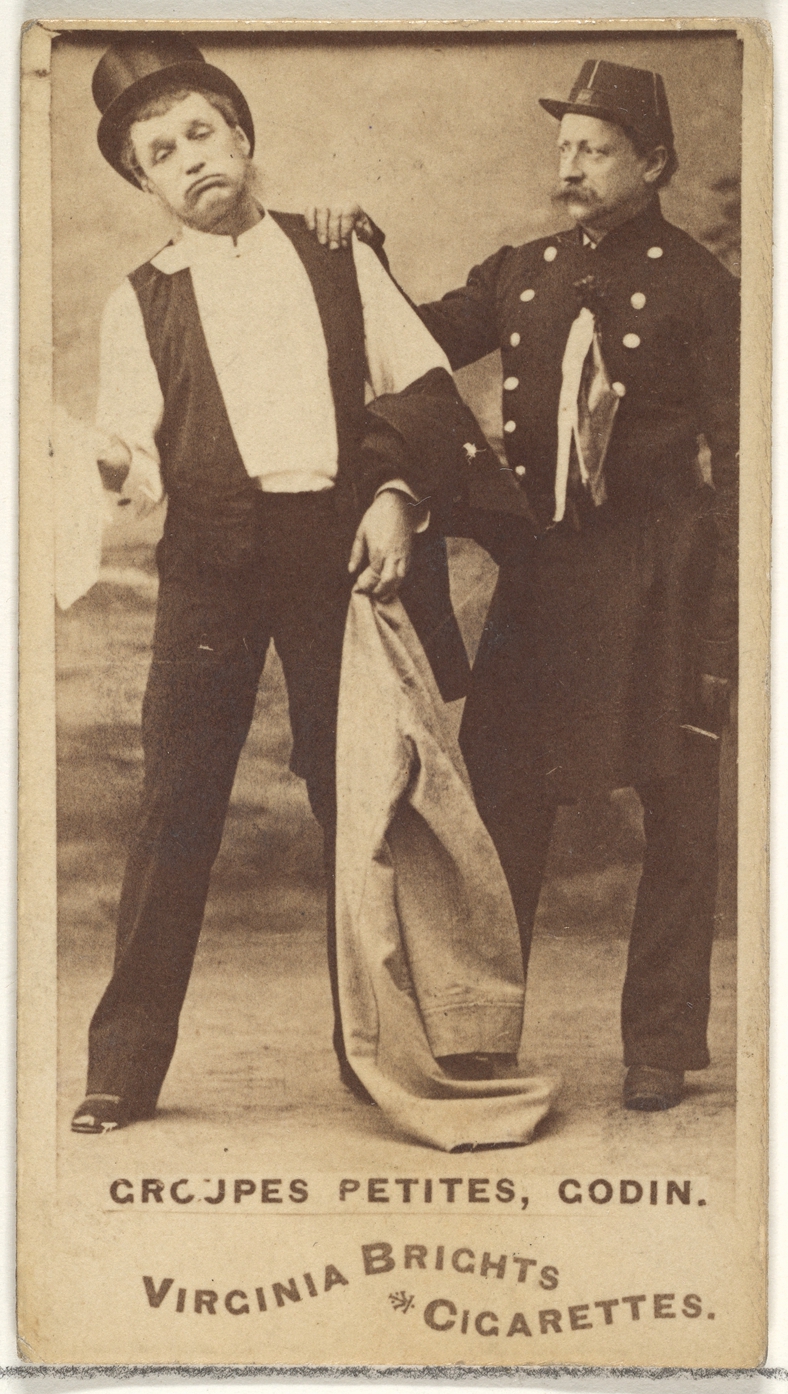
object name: photograph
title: Groupes Petites, Godin, from the Actors and Actresses series (N45, Type 1) for Virginia Brights Cigarettes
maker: allen & ginter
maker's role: publisher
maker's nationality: american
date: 1888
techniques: albumen silver print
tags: men,portraits,actors